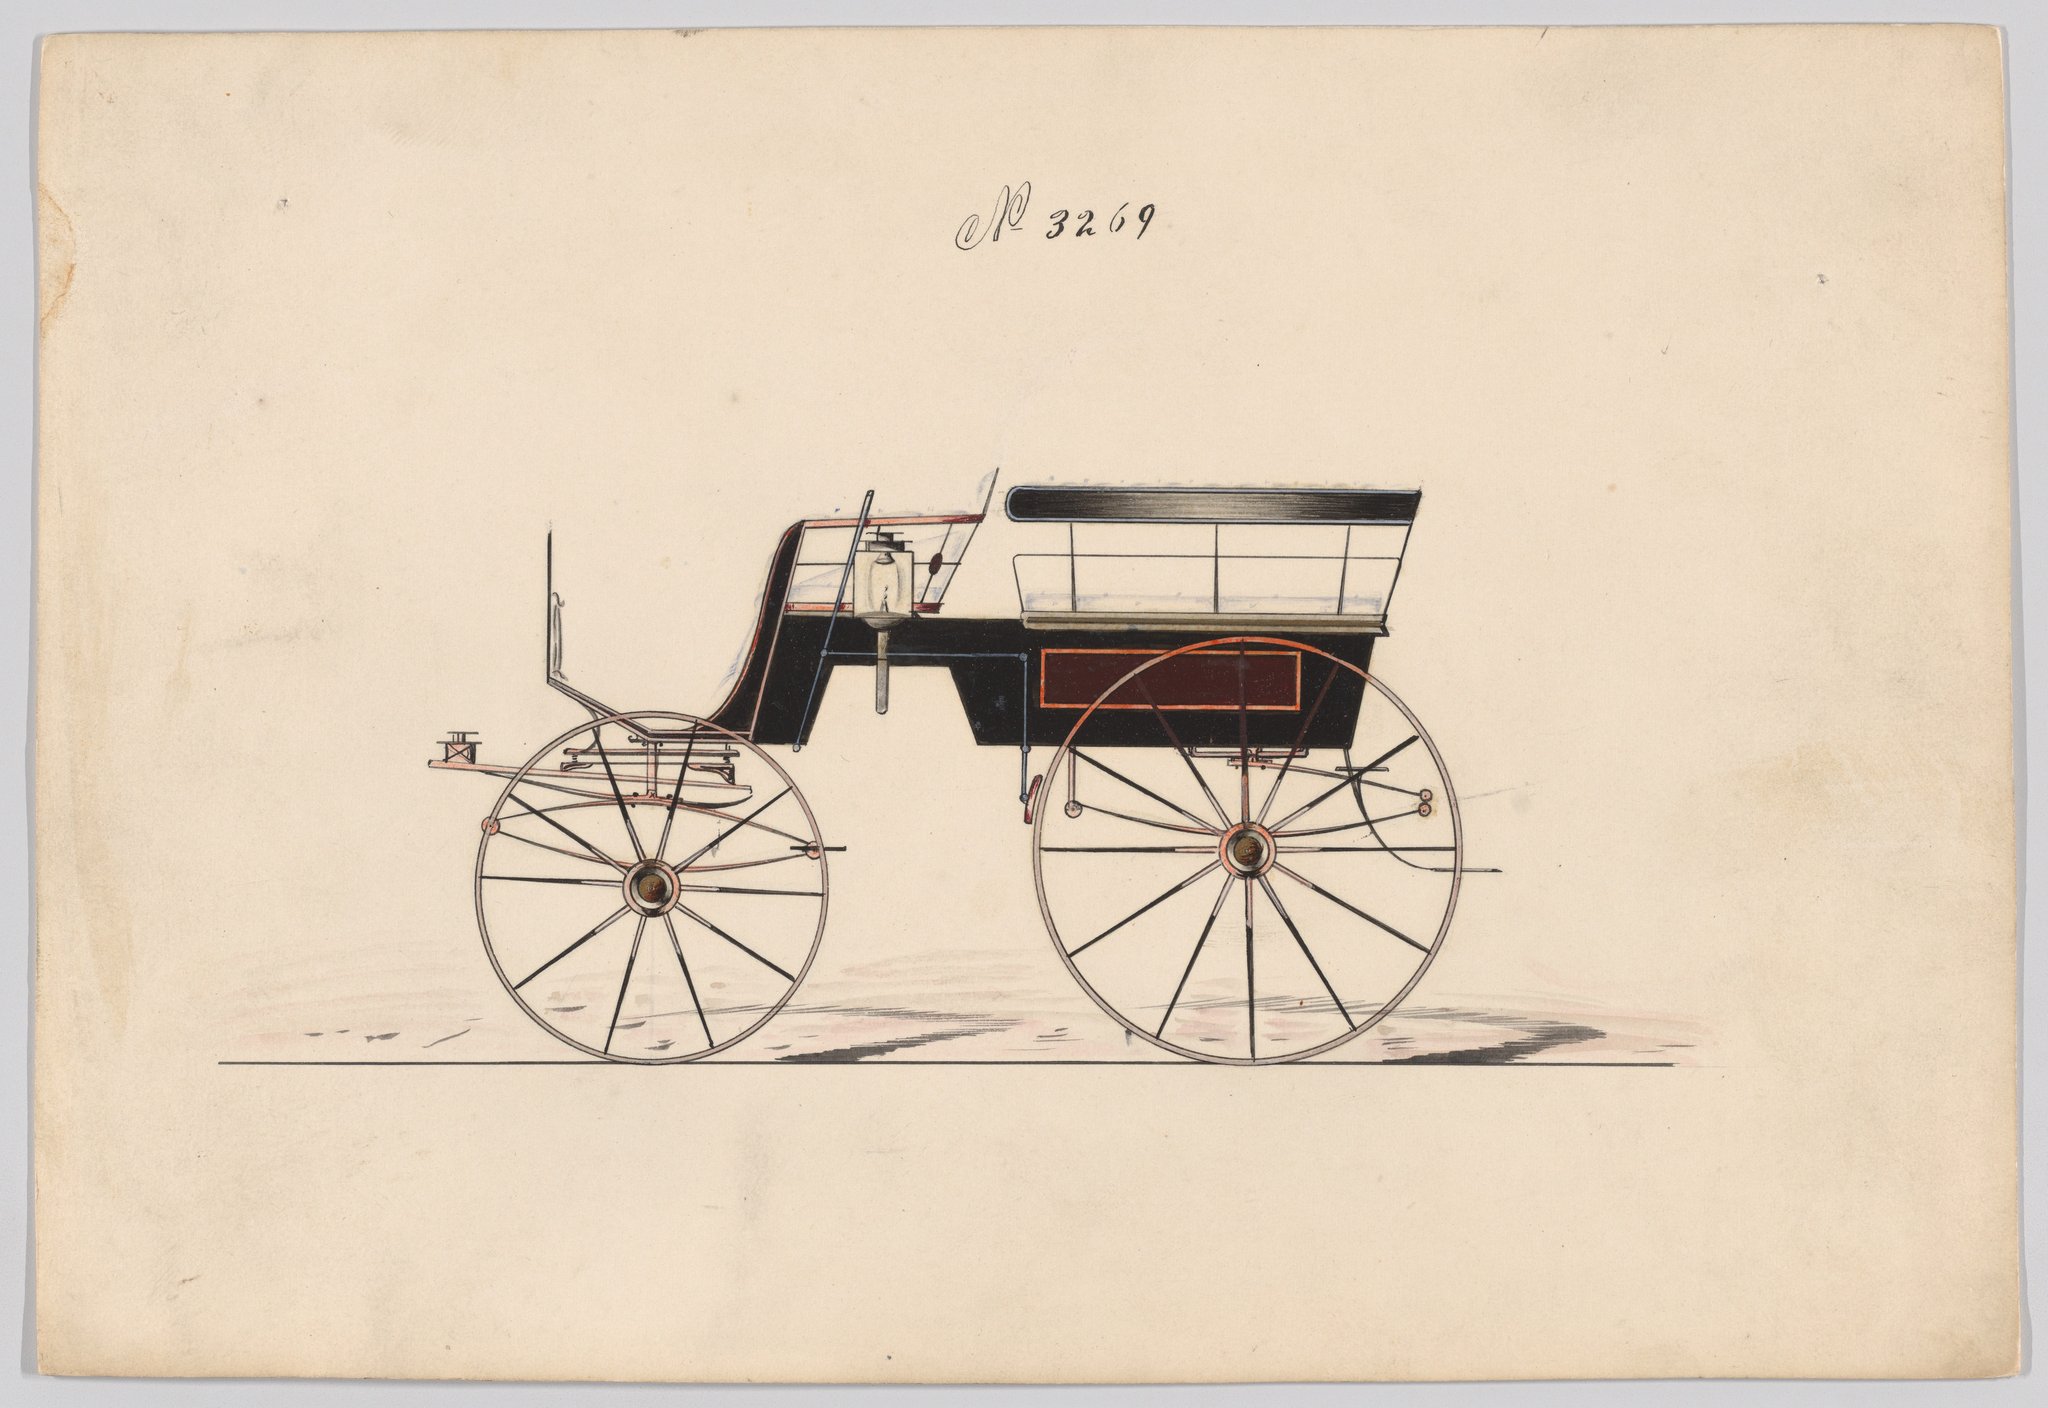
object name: drawing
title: Design for Omnibus or Wagonette, no. 3269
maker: brewster & co.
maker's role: manufacturer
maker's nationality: american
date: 1876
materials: gouache, ink, watercolor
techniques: pen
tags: carriages